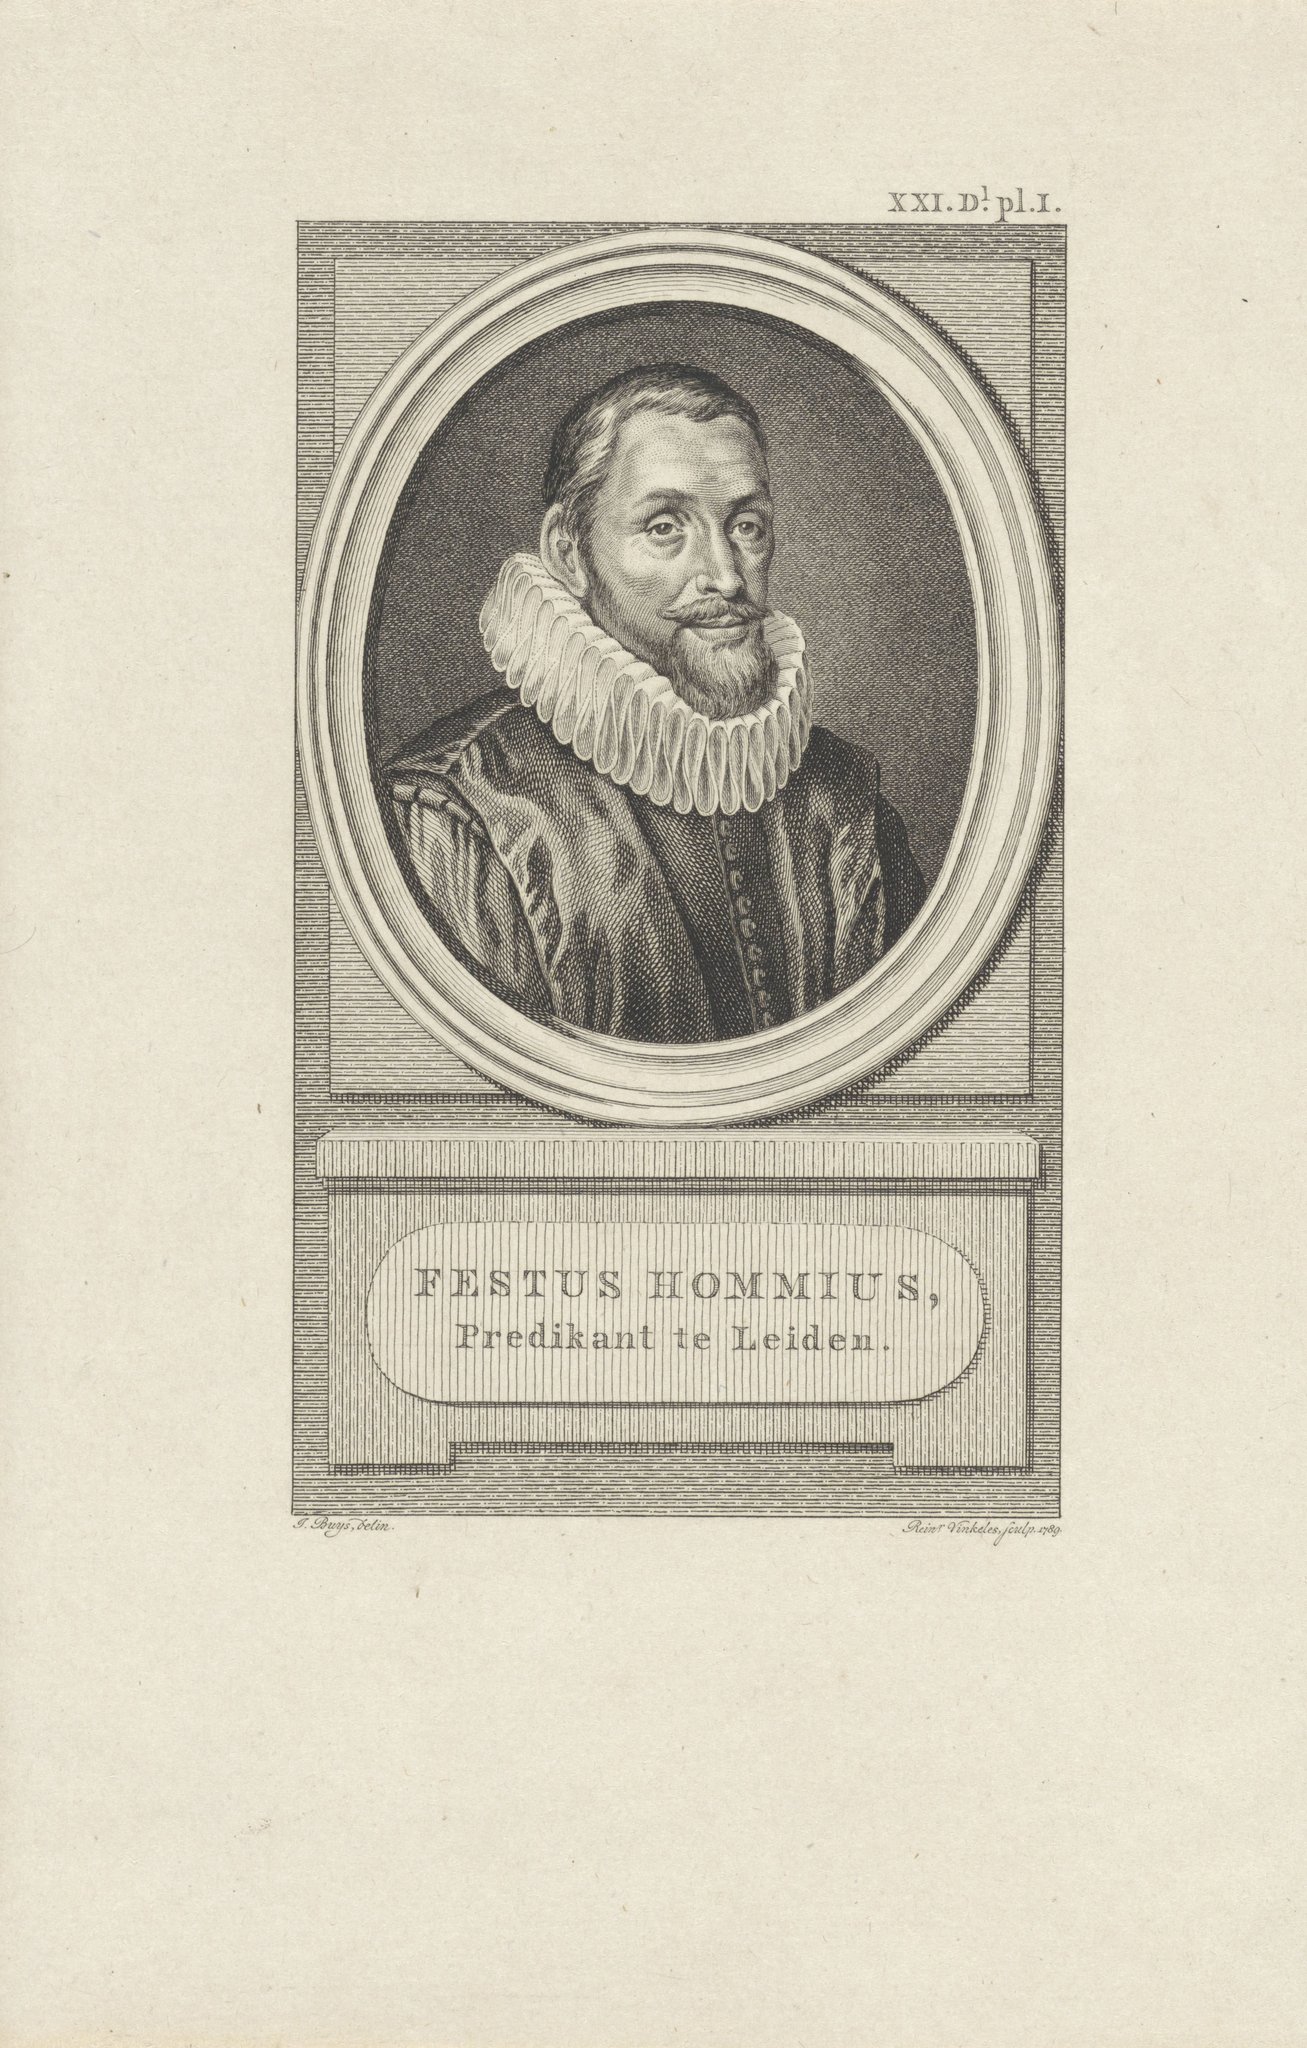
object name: book illustration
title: Portret van Festus Hommius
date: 1789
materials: paper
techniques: engraving, etching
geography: amsterdam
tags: theologian, adult man, historical persons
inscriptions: collector's mark: Lugt 2228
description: Prent gebruikt als boekillustratie in: Kok, Jacobus. Vaderlandsch woordenboek : met kaarten, plaaten en pourtraitten. Amsterdam: Johannes Allart, 1785-1796. Deel XXI.